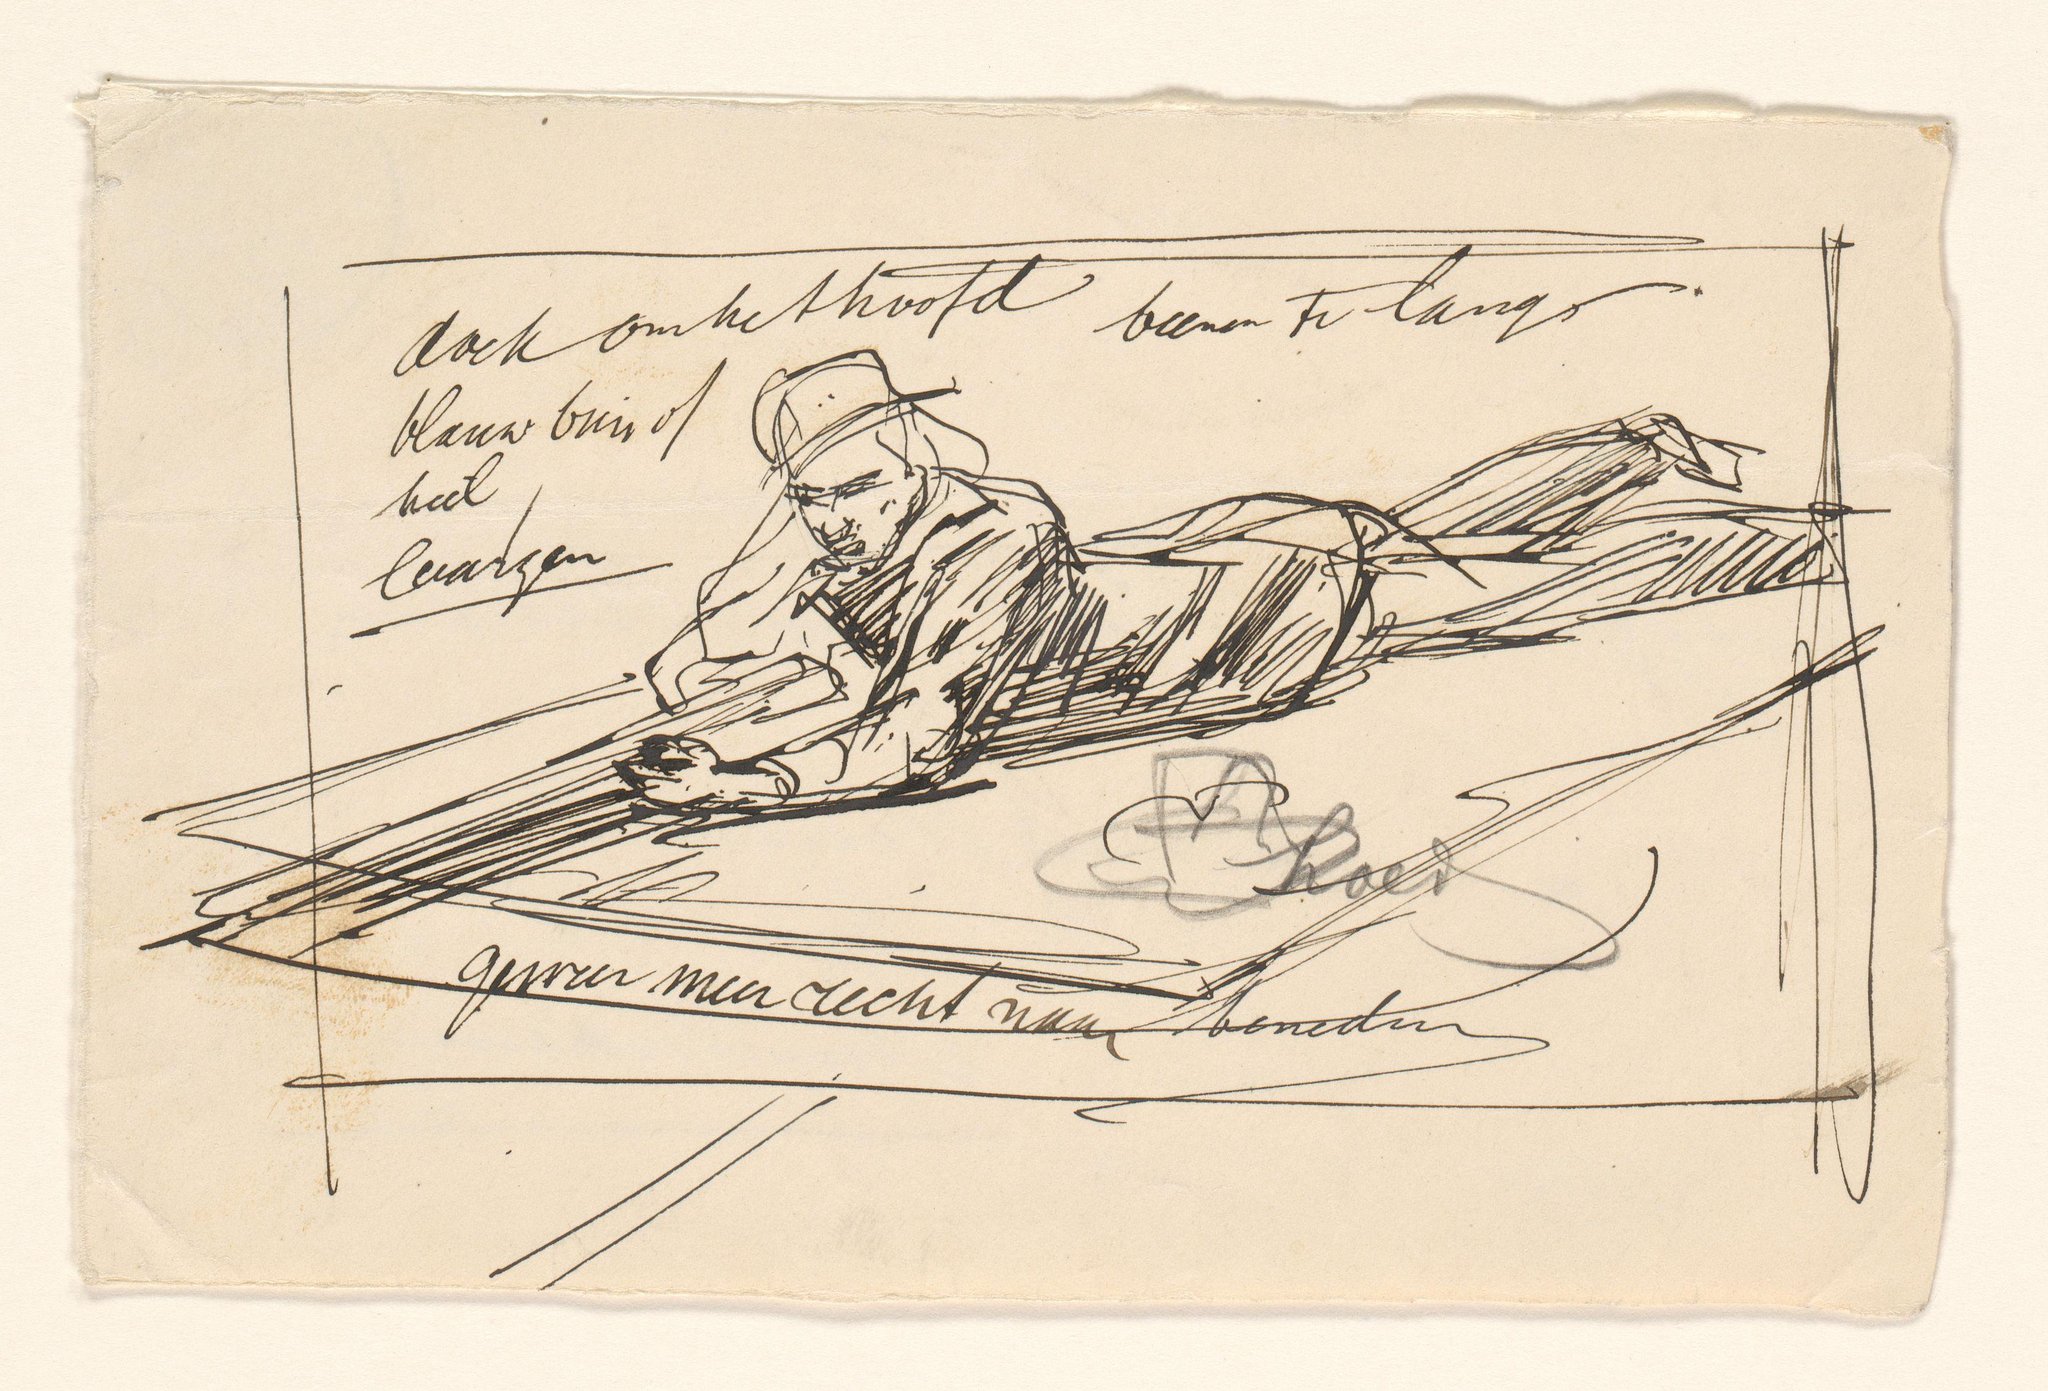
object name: drawing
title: Studie van een liggende man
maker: august allebé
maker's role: draughtsman, print maker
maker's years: 1838-1927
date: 1848-1927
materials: ink, paper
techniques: pen